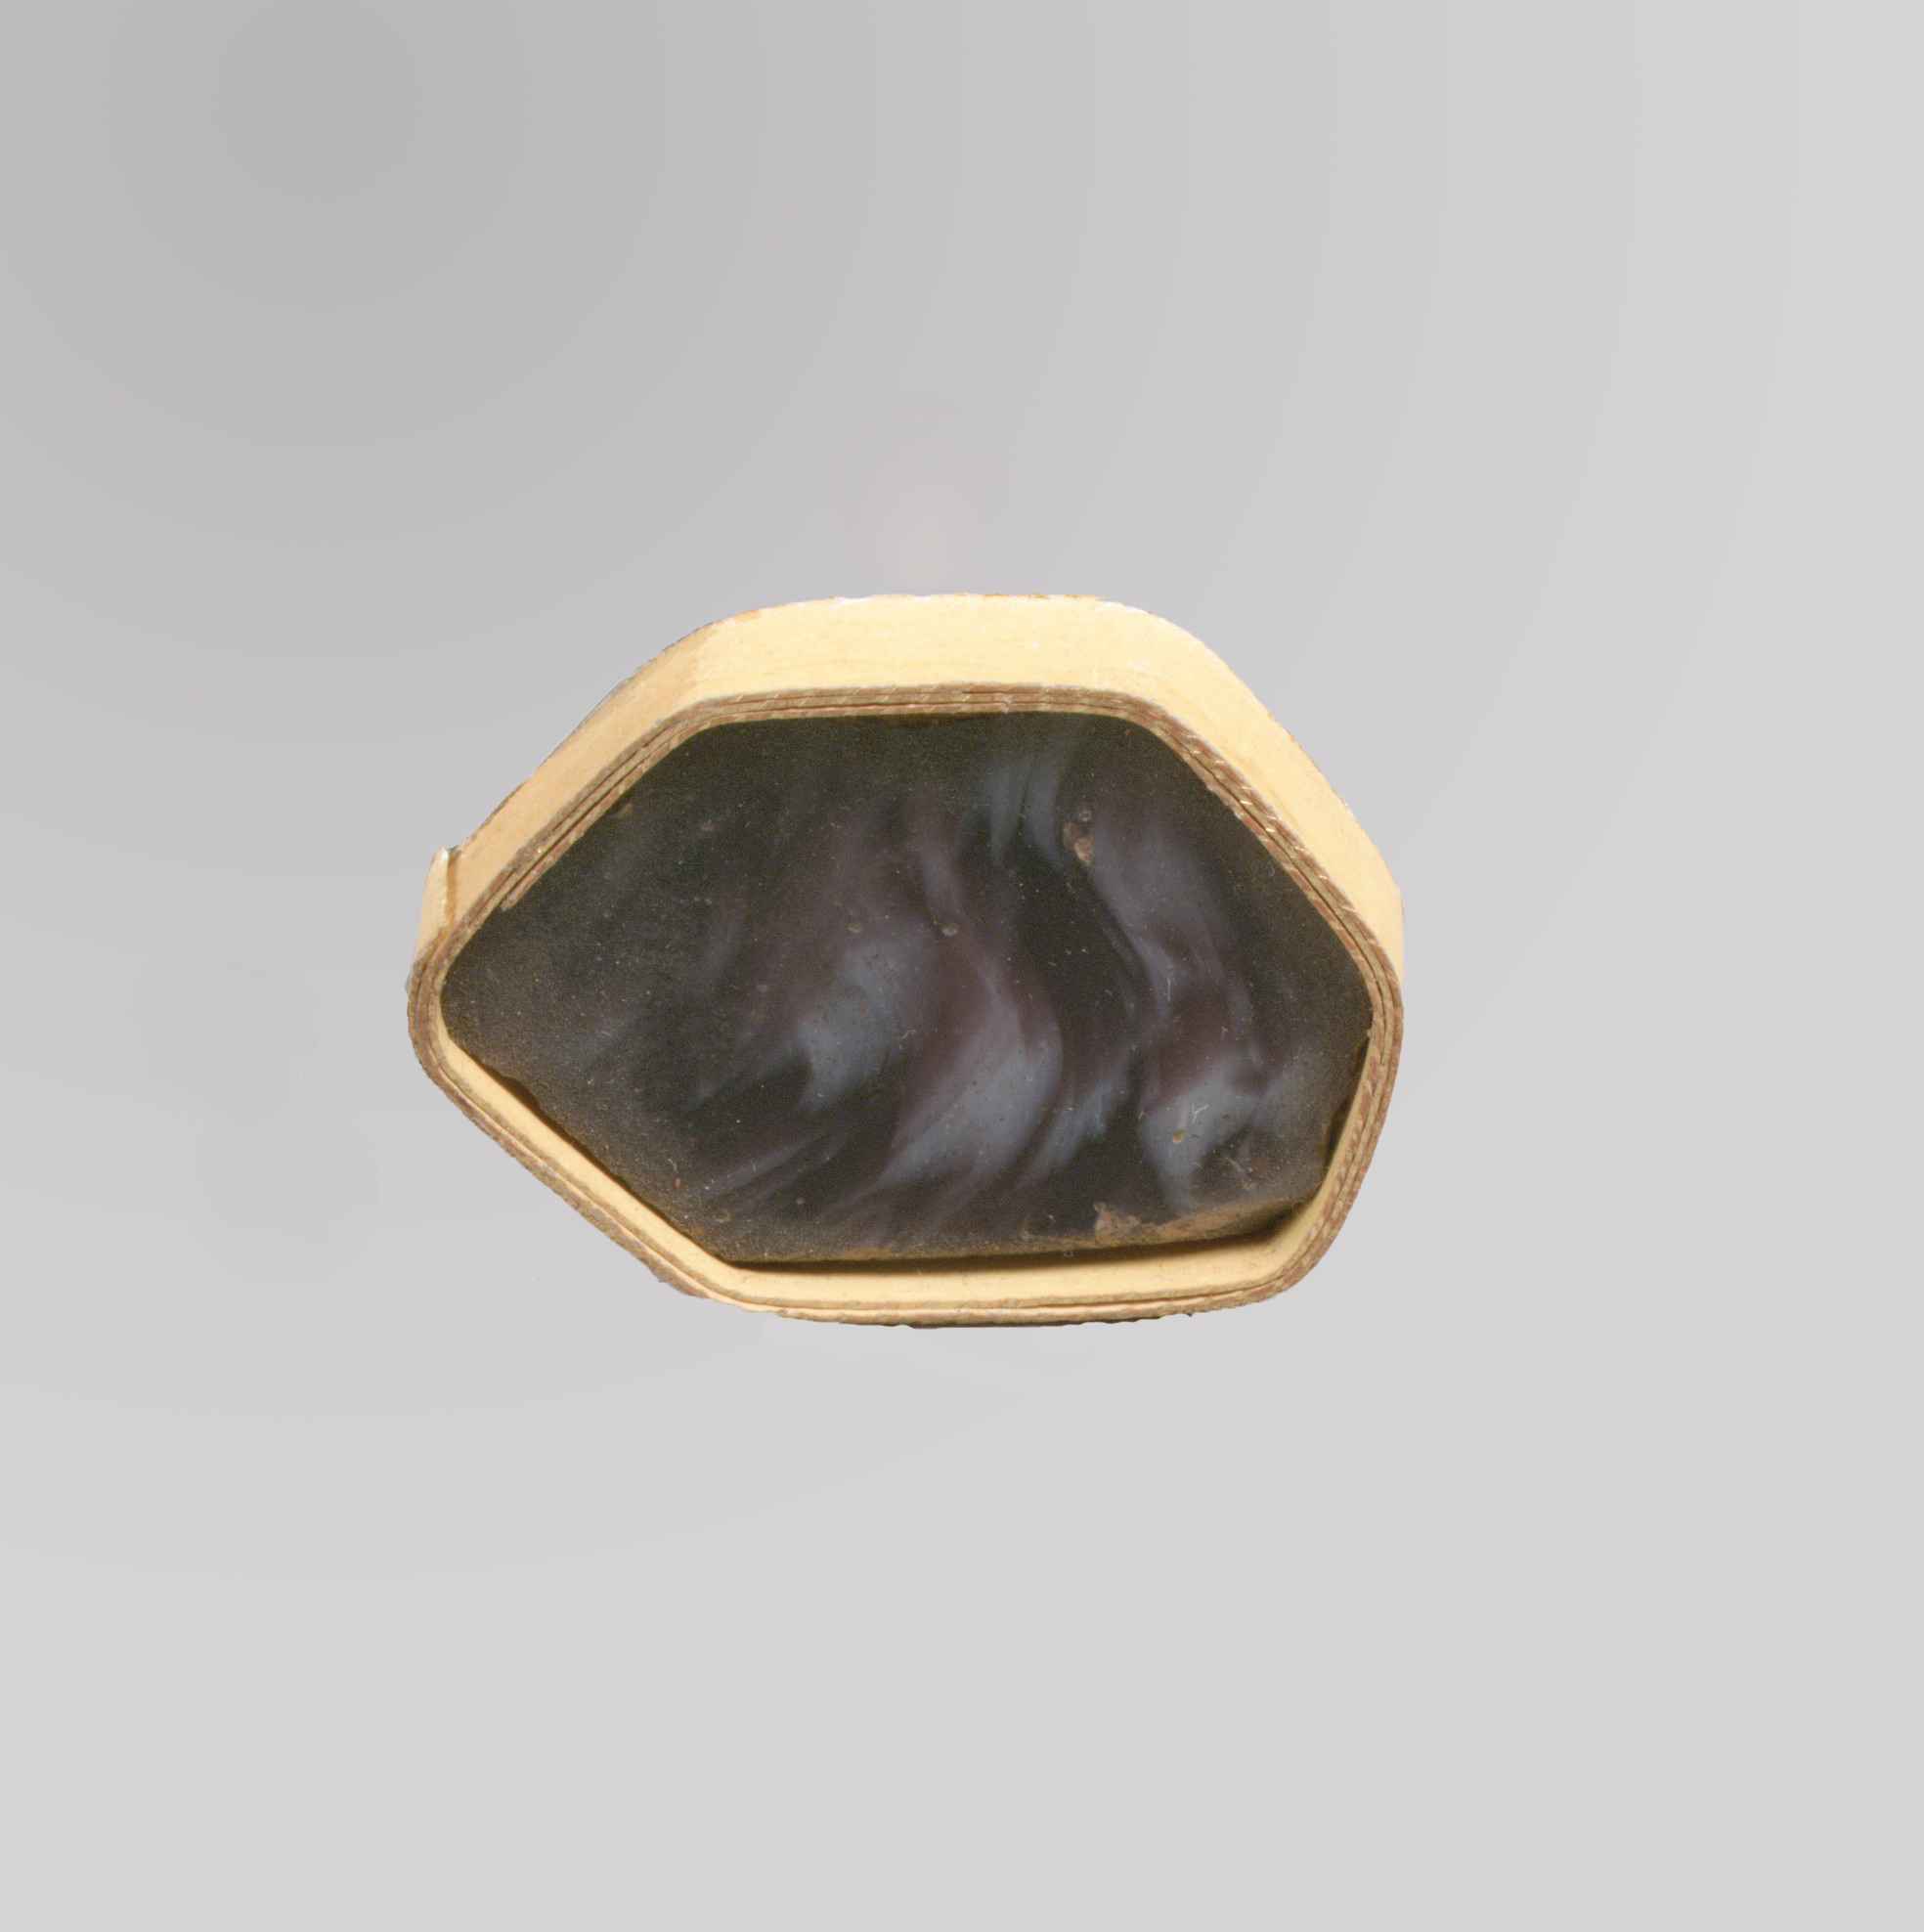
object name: fragment, mosaic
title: Glass mosaic inlay fragment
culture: roman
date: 34 BCE-33 CE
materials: glass